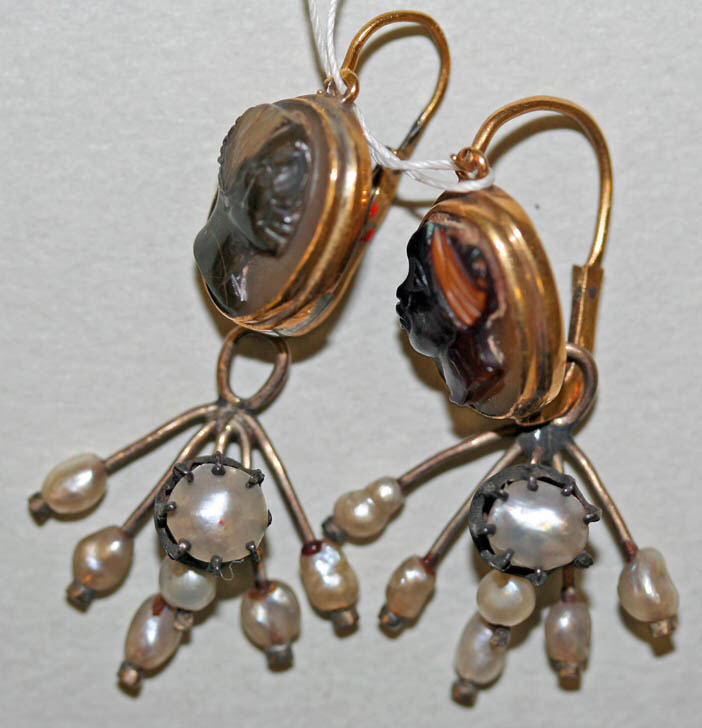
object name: earring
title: Earrings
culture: european, eastern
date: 1701-1900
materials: metal